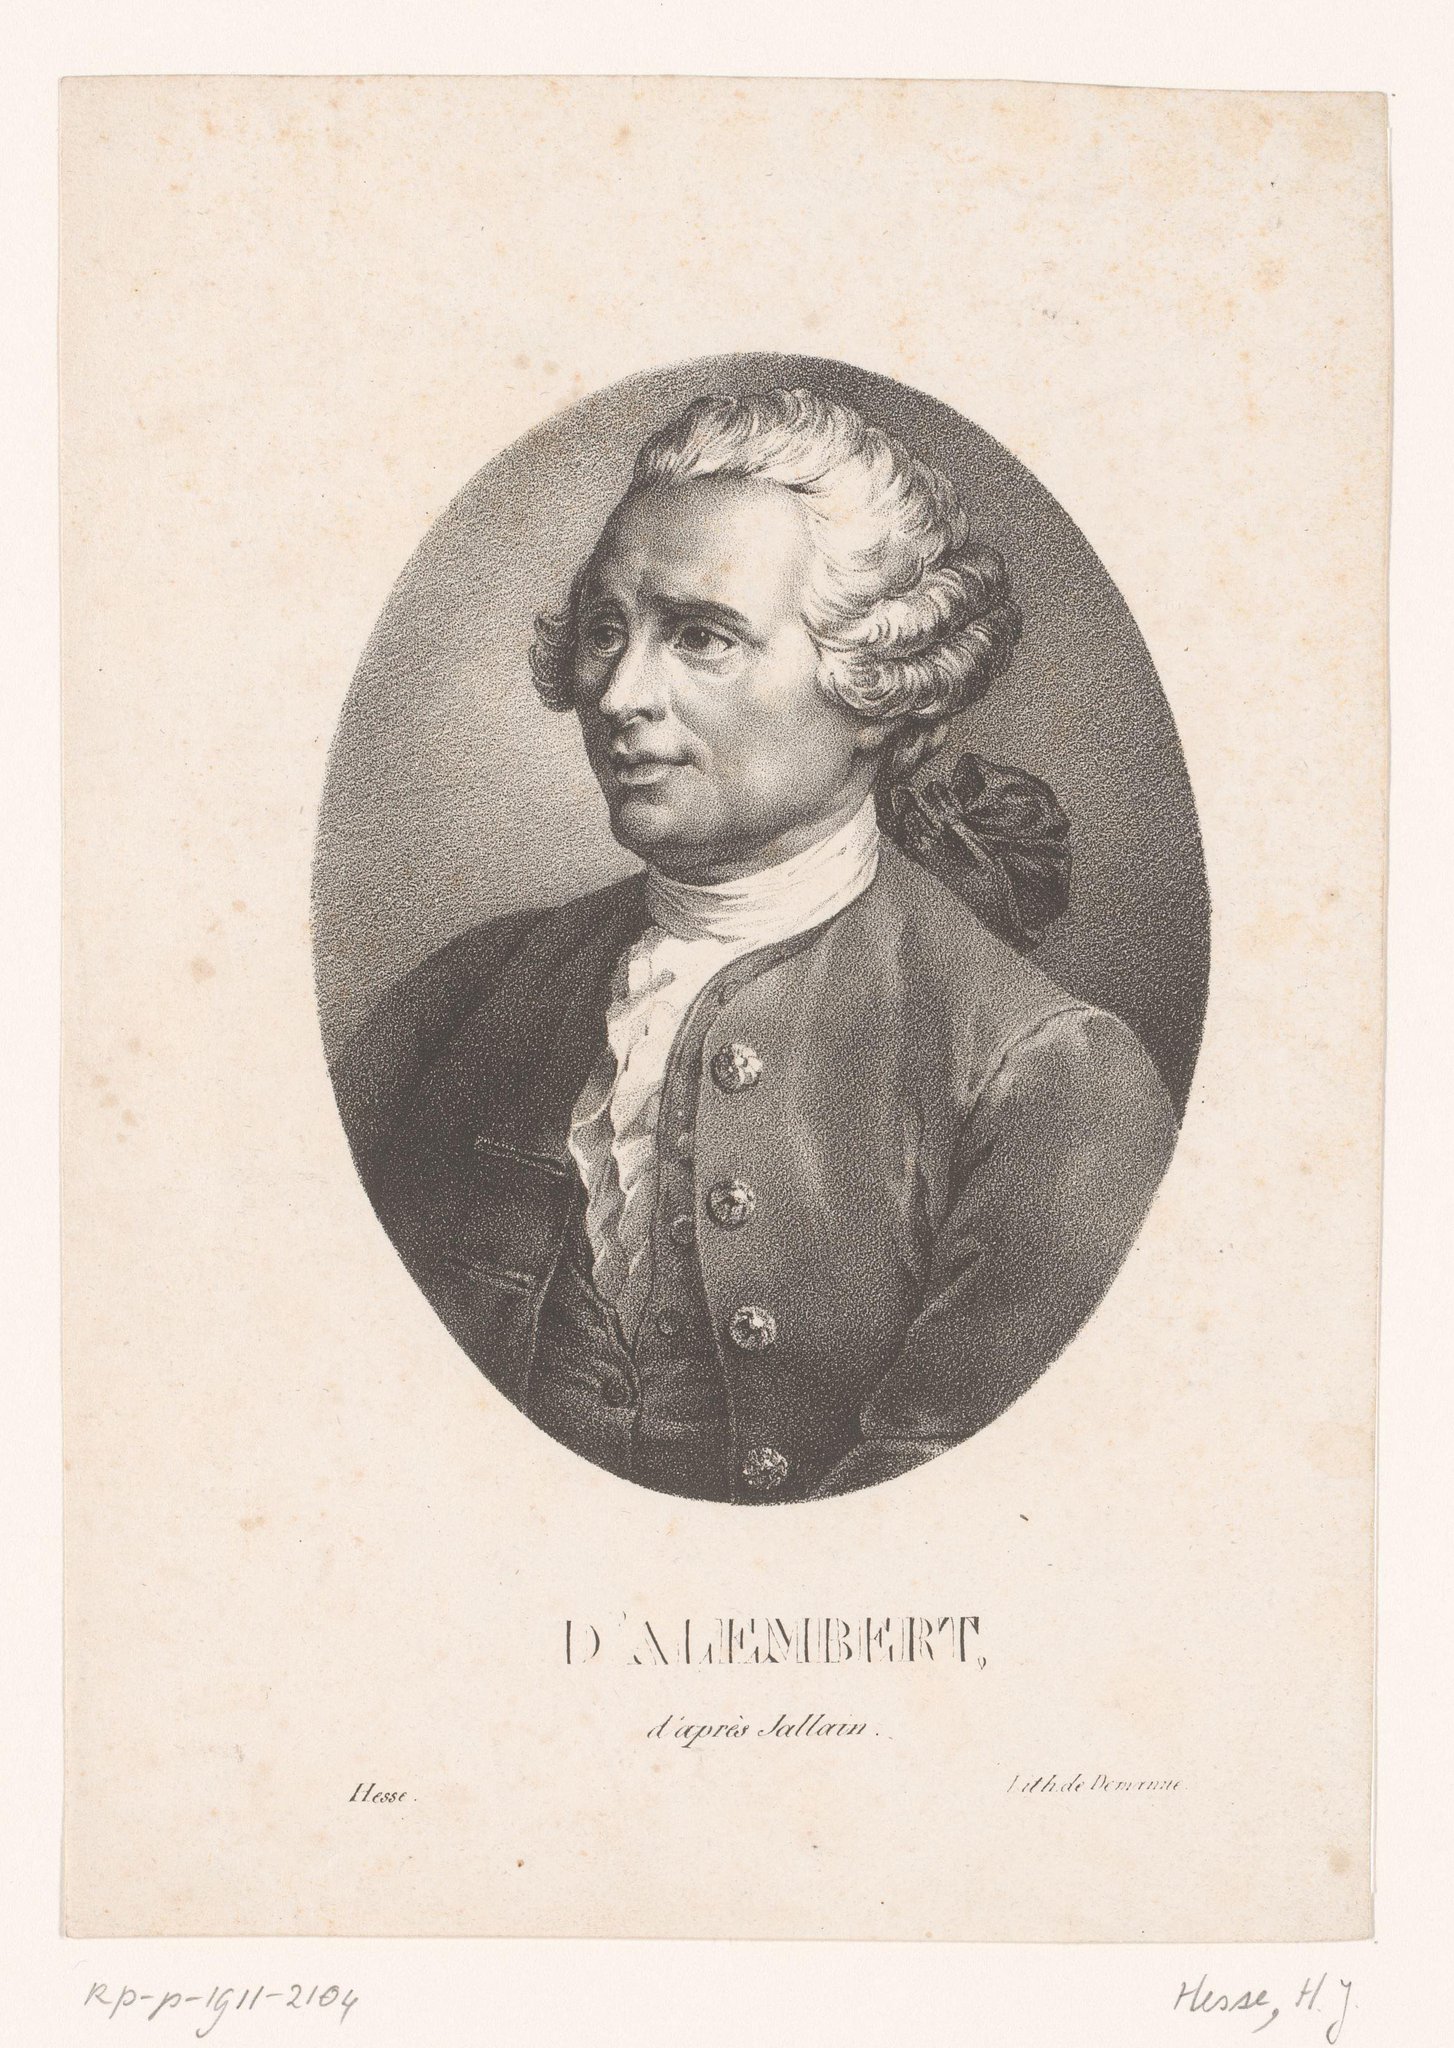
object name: print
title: Portret van Jean Le Rond d'Alembert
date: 1822-1830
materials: paper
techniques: lithograph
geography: paris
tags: historical persons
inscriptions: collector's mark: Lugt 2228a